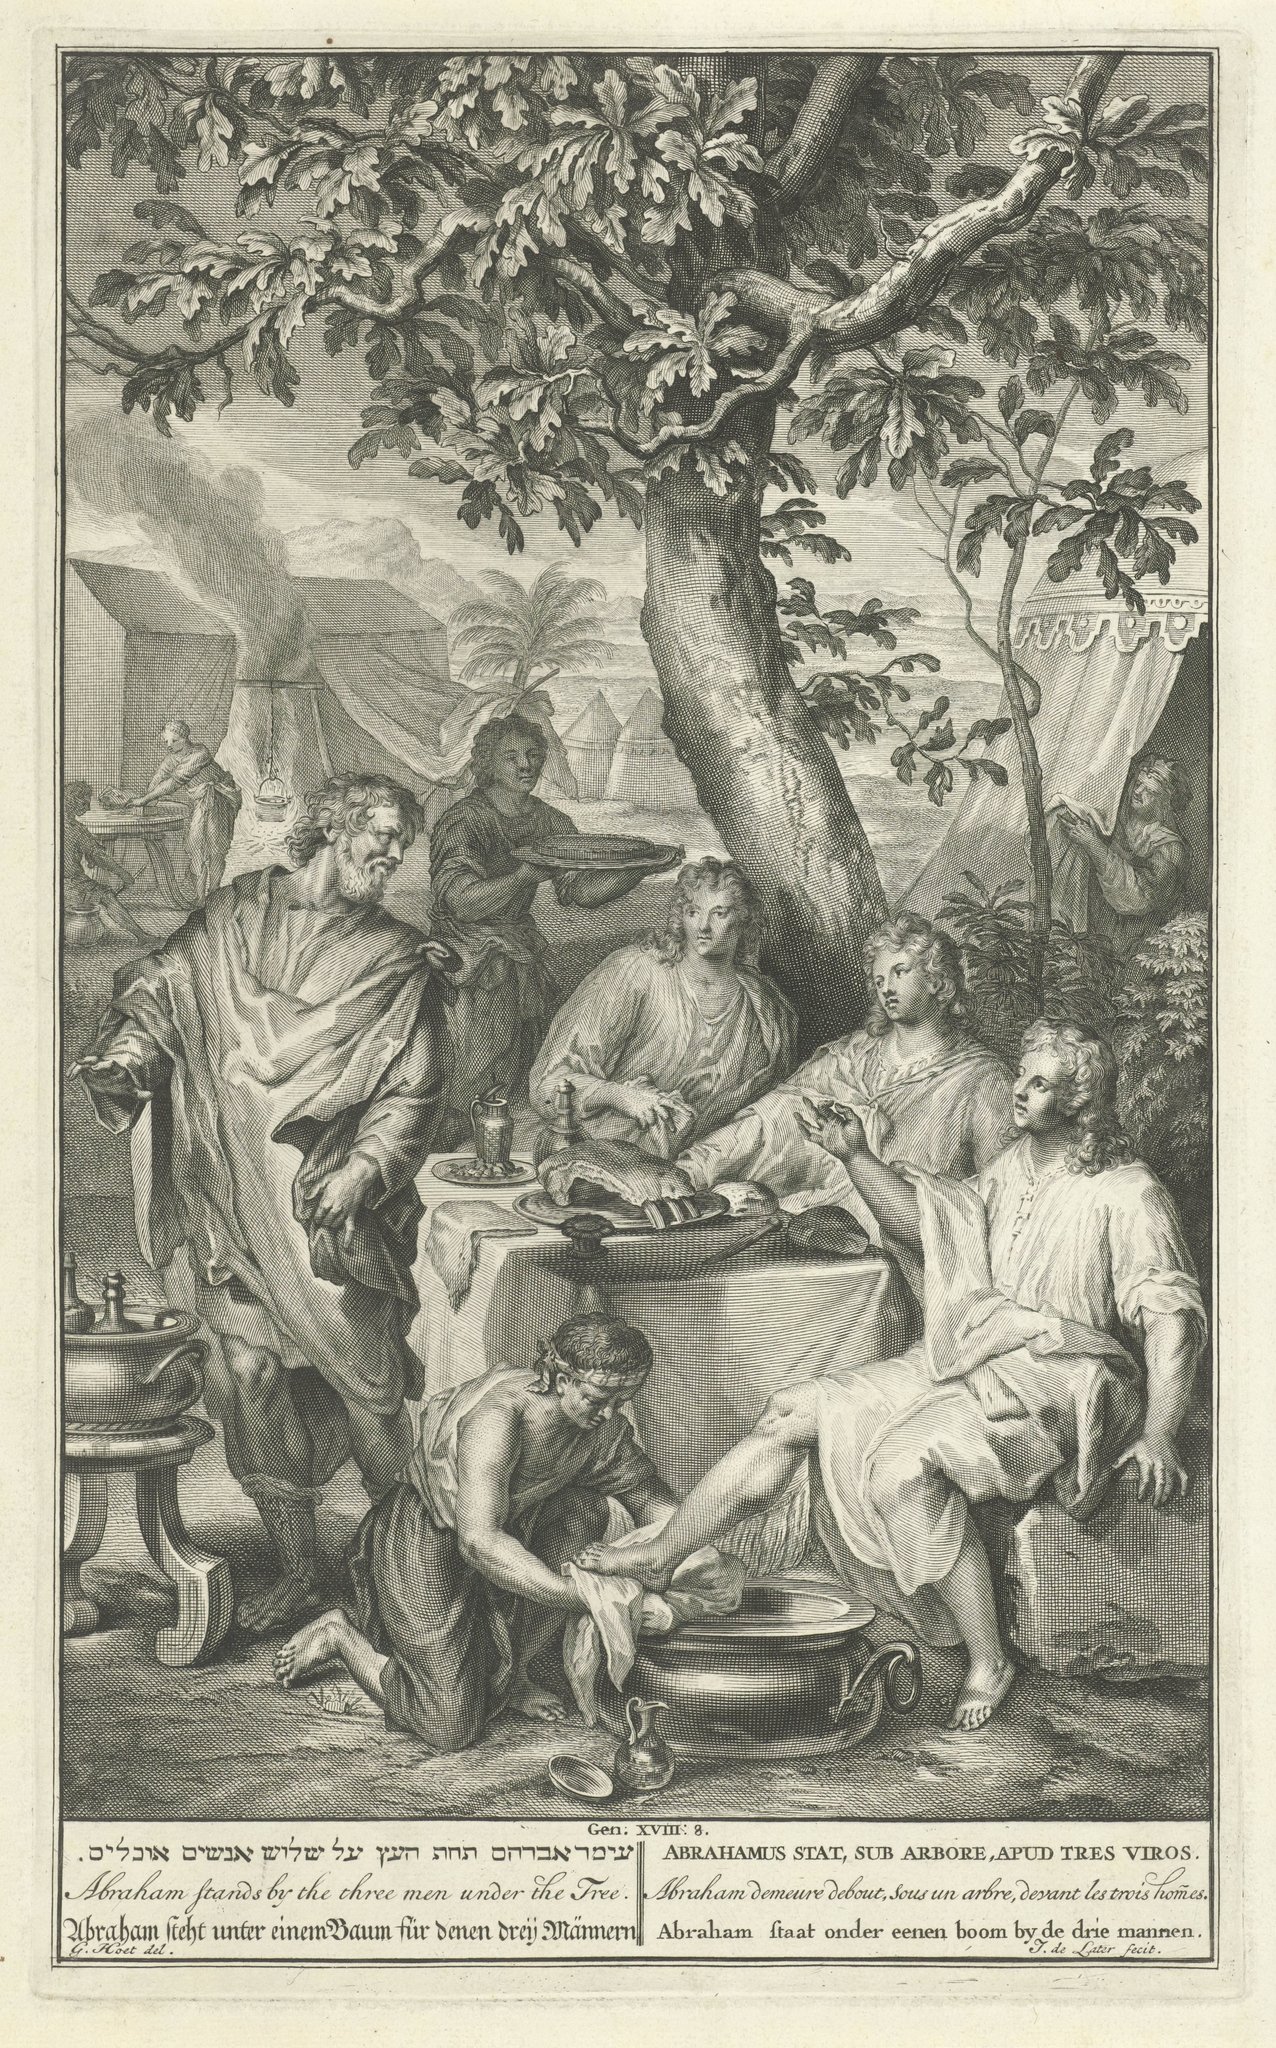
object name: print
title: Abraham ontvangt de drie engelen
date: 1728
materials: paper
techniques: engraving, etching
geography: amsterdam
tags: the visit of the three angels (three men) ~ story of abraham (genesis 18)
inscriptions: collector's mark: Lugt 2228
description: Prent gemaakt voor: Figures de la Bible. Amsterdam, Bernard Picart, 1720. Prent ook gebruikt in: Taferelen der voornaamste geschiedenissen van het Oude en Nieuwe Testament (...) door de vermaarde kunstenaars Hoet, Houbraken, en Picart getekent (...) en met beschrijvingen uitgebreid. Den Haag: Pieter de Hondt, 1728.